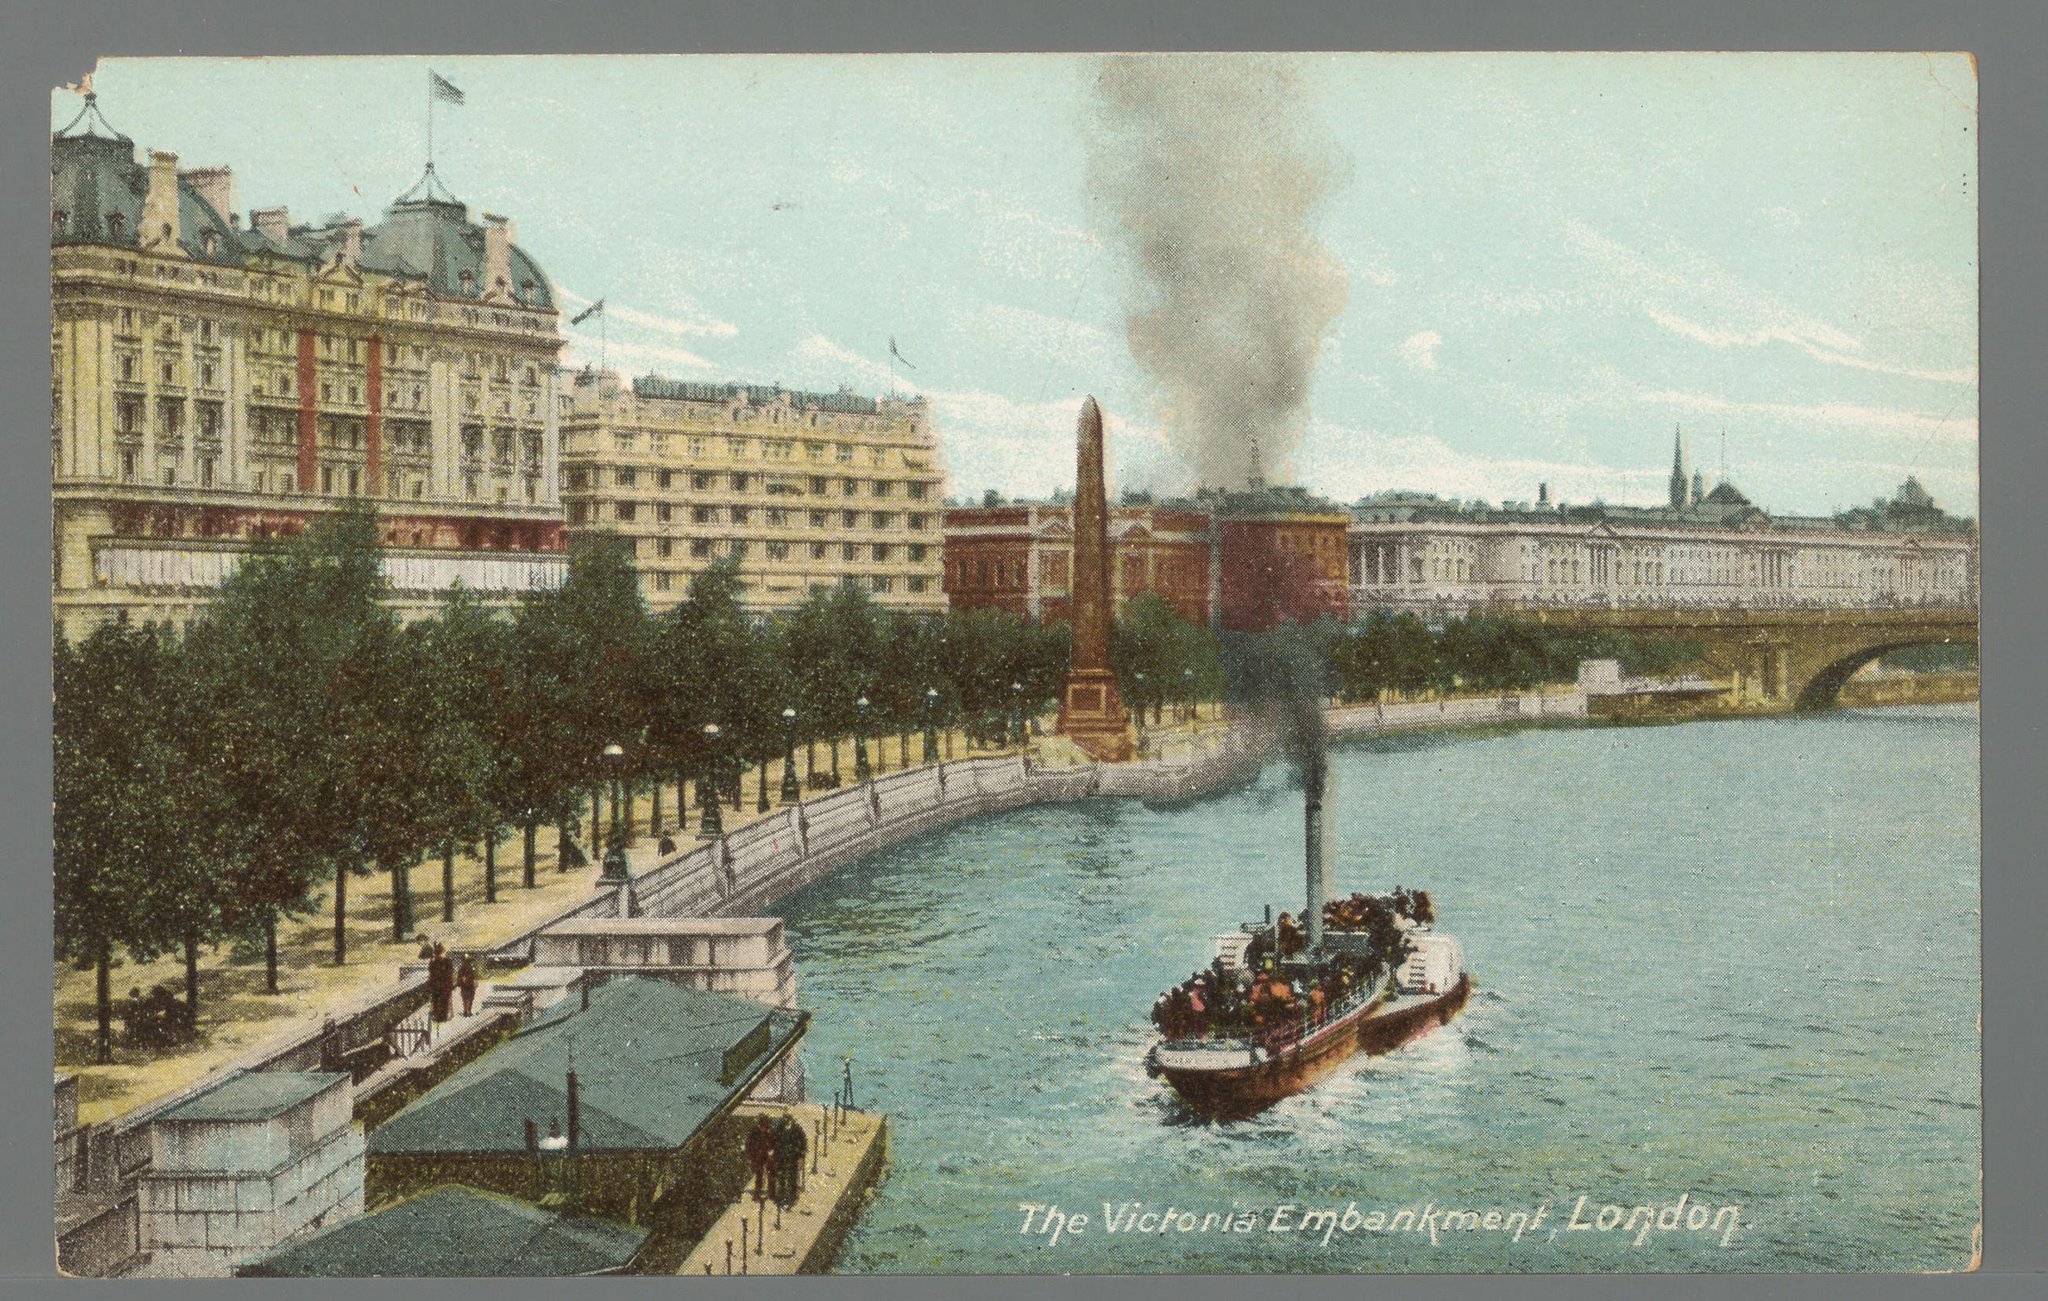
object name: ansichtkaart, prentbriefkaart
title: The Victoria Embarkment, London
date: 1903-1916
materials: cardboard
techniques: lithograph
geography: london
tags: canals, waters (in city), bridge in city across river, canal, etc., quay, thames